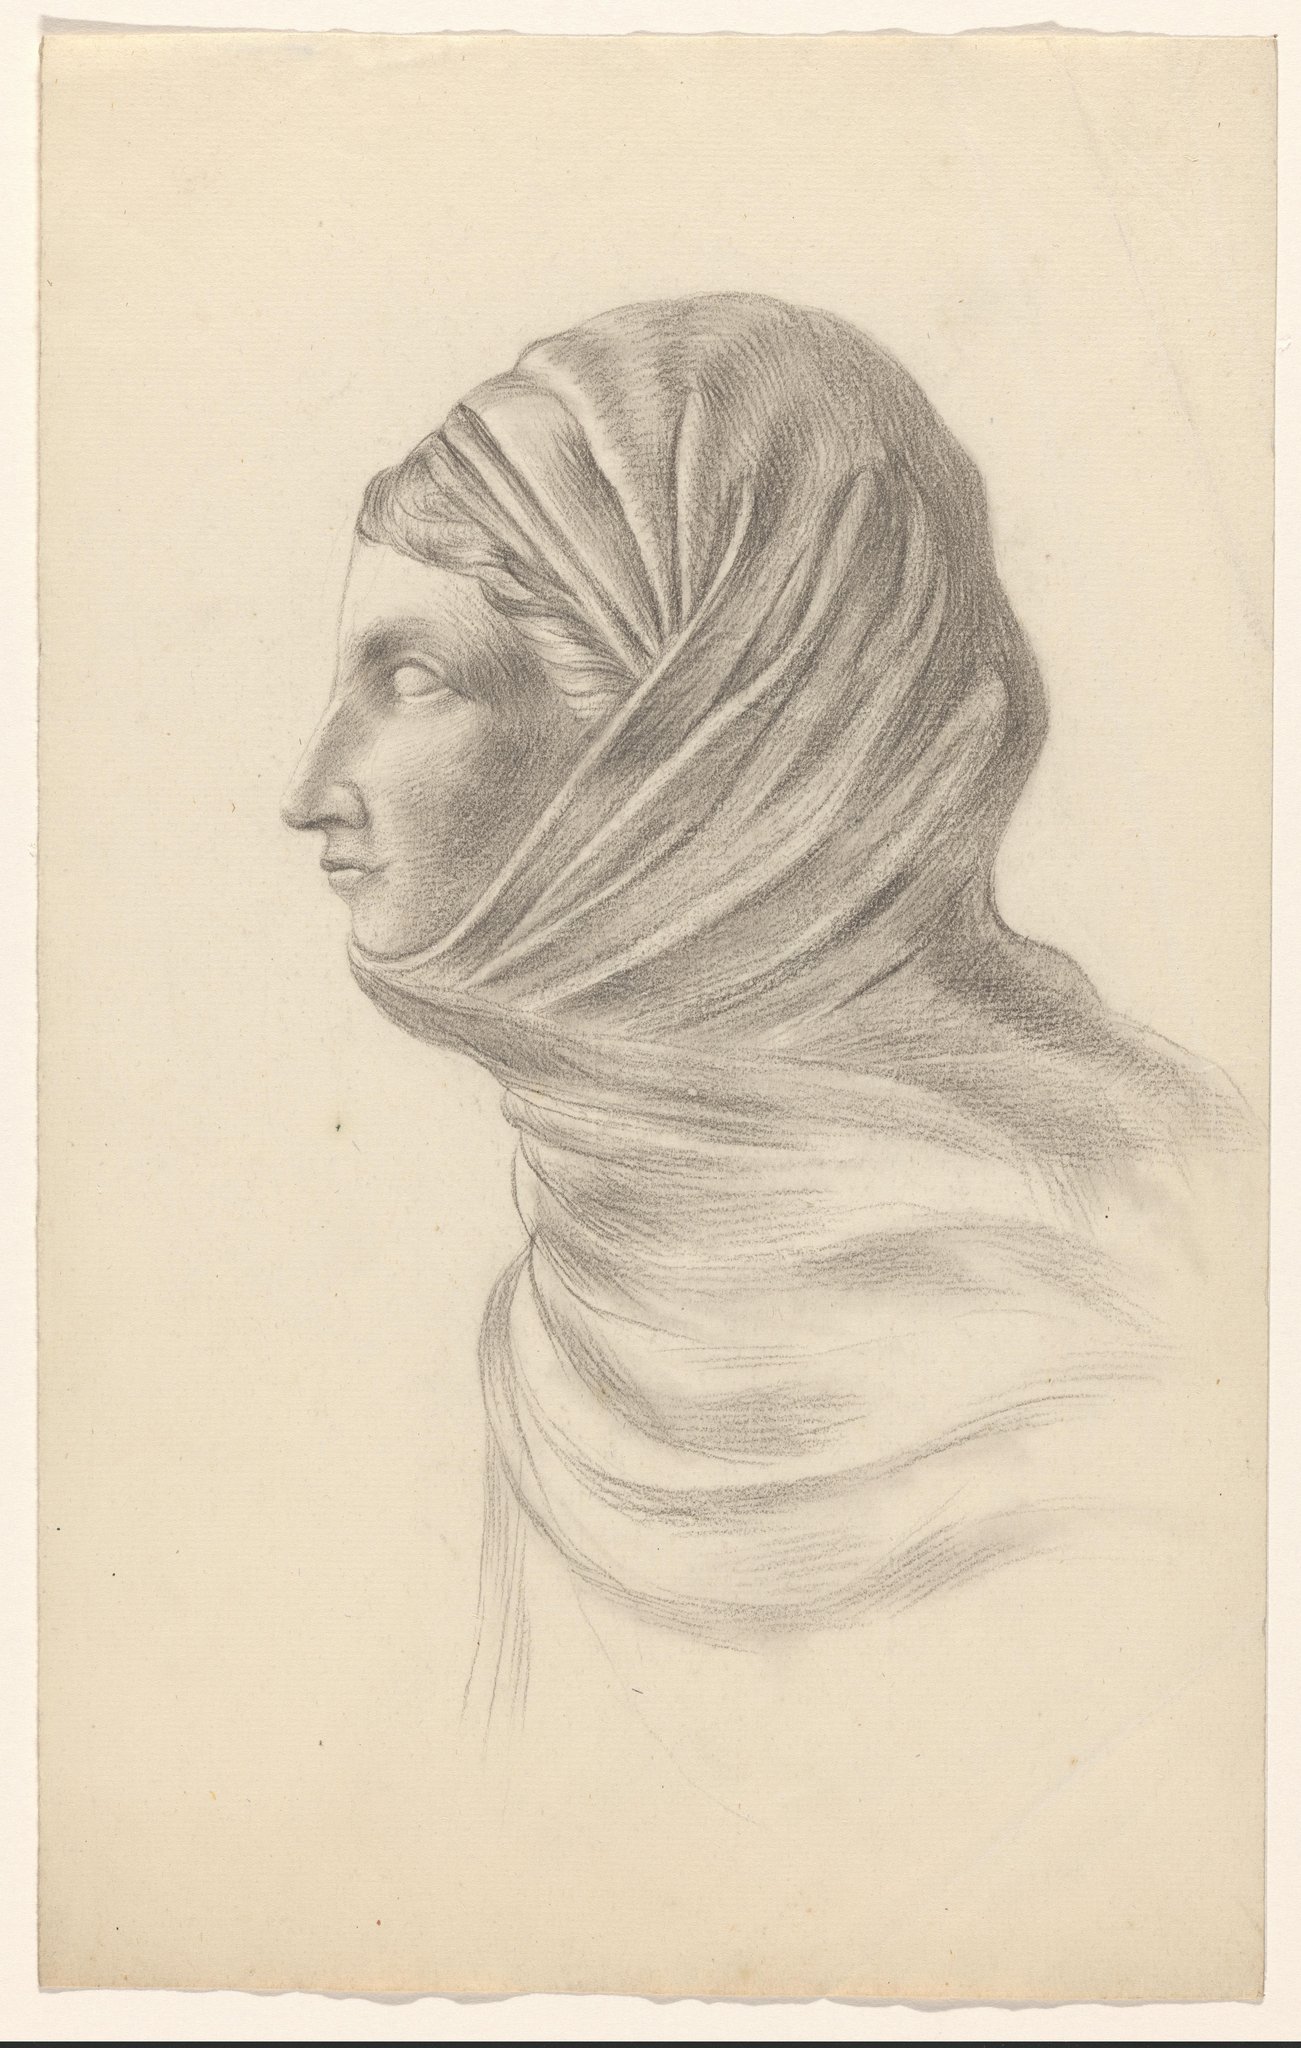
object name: drawing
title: Studie van buste van een vrouw met hoofddoek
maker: Anonymous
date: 1830-1880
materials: chalk, paper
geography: netherlands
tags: head-gear, sculpture, classical antiquity (historical epoch)